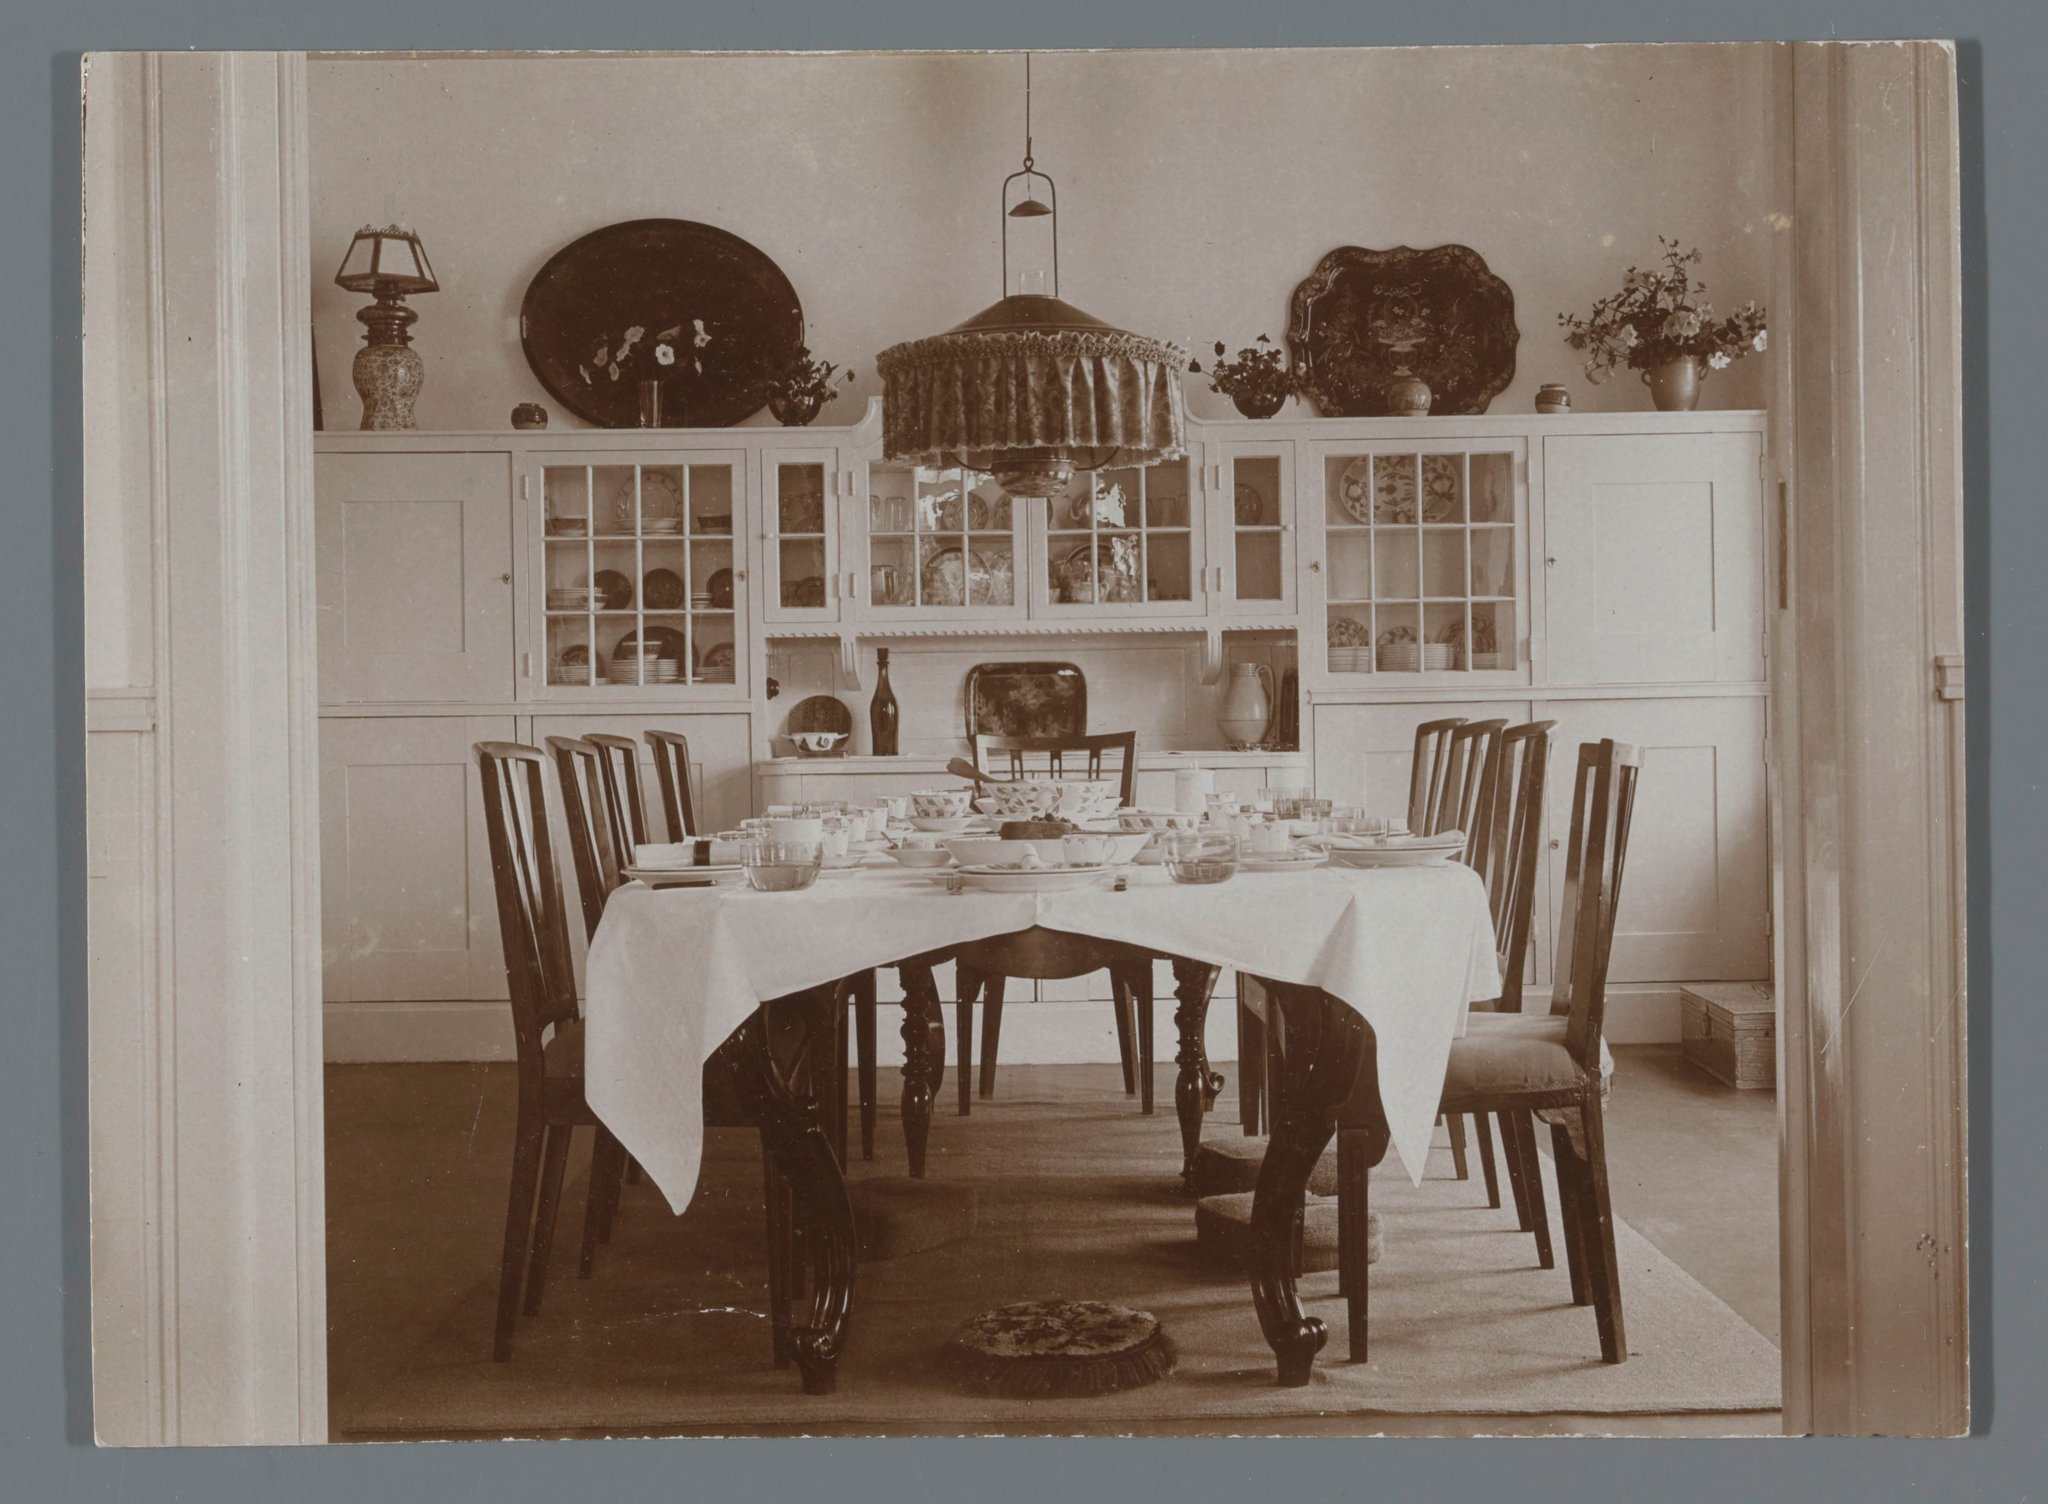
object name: photograph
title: Eetkamer met gedekte tafel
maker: cornelia hendrika jonker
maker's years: 1874-1924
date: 1880-1940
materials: photographic support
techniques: collodion silver print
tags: interior of the house, dining-room